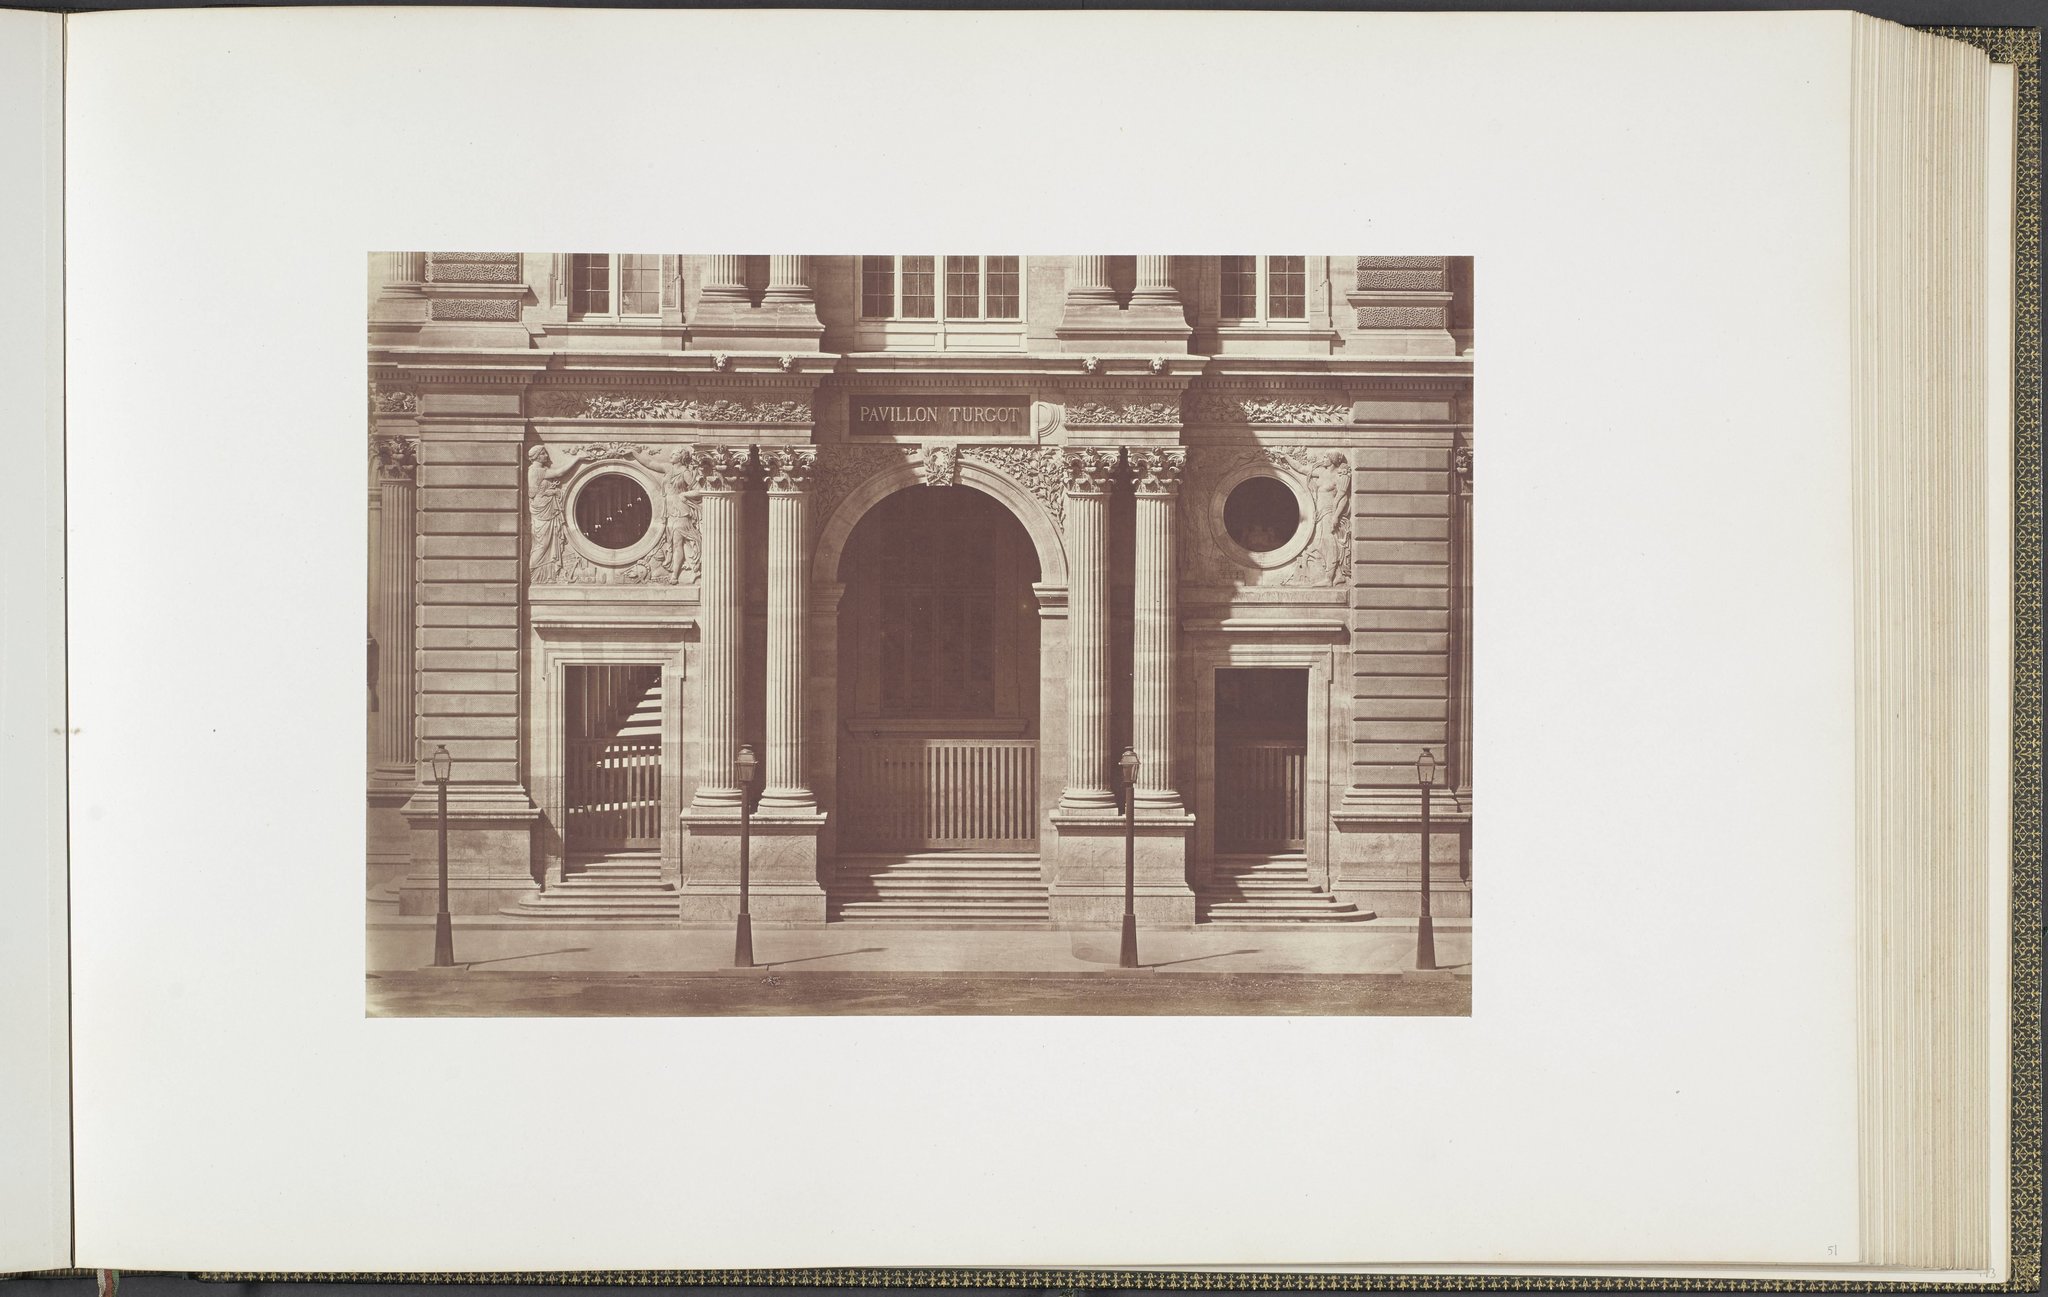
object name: photograph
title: Begane grond van het Pavillon Turgot van het Palais du Louvre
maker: édouard denis baldus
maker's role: fotograaf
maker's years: 1813-1889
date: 1857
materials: paper, photographic support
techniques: salted paper print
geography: paris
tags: permanent exhibition, museum, façade (of house or building), paris, tuileries palace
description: Onderdeel van Réunion des Tuileries au Louvre 1852-1857, album 1.